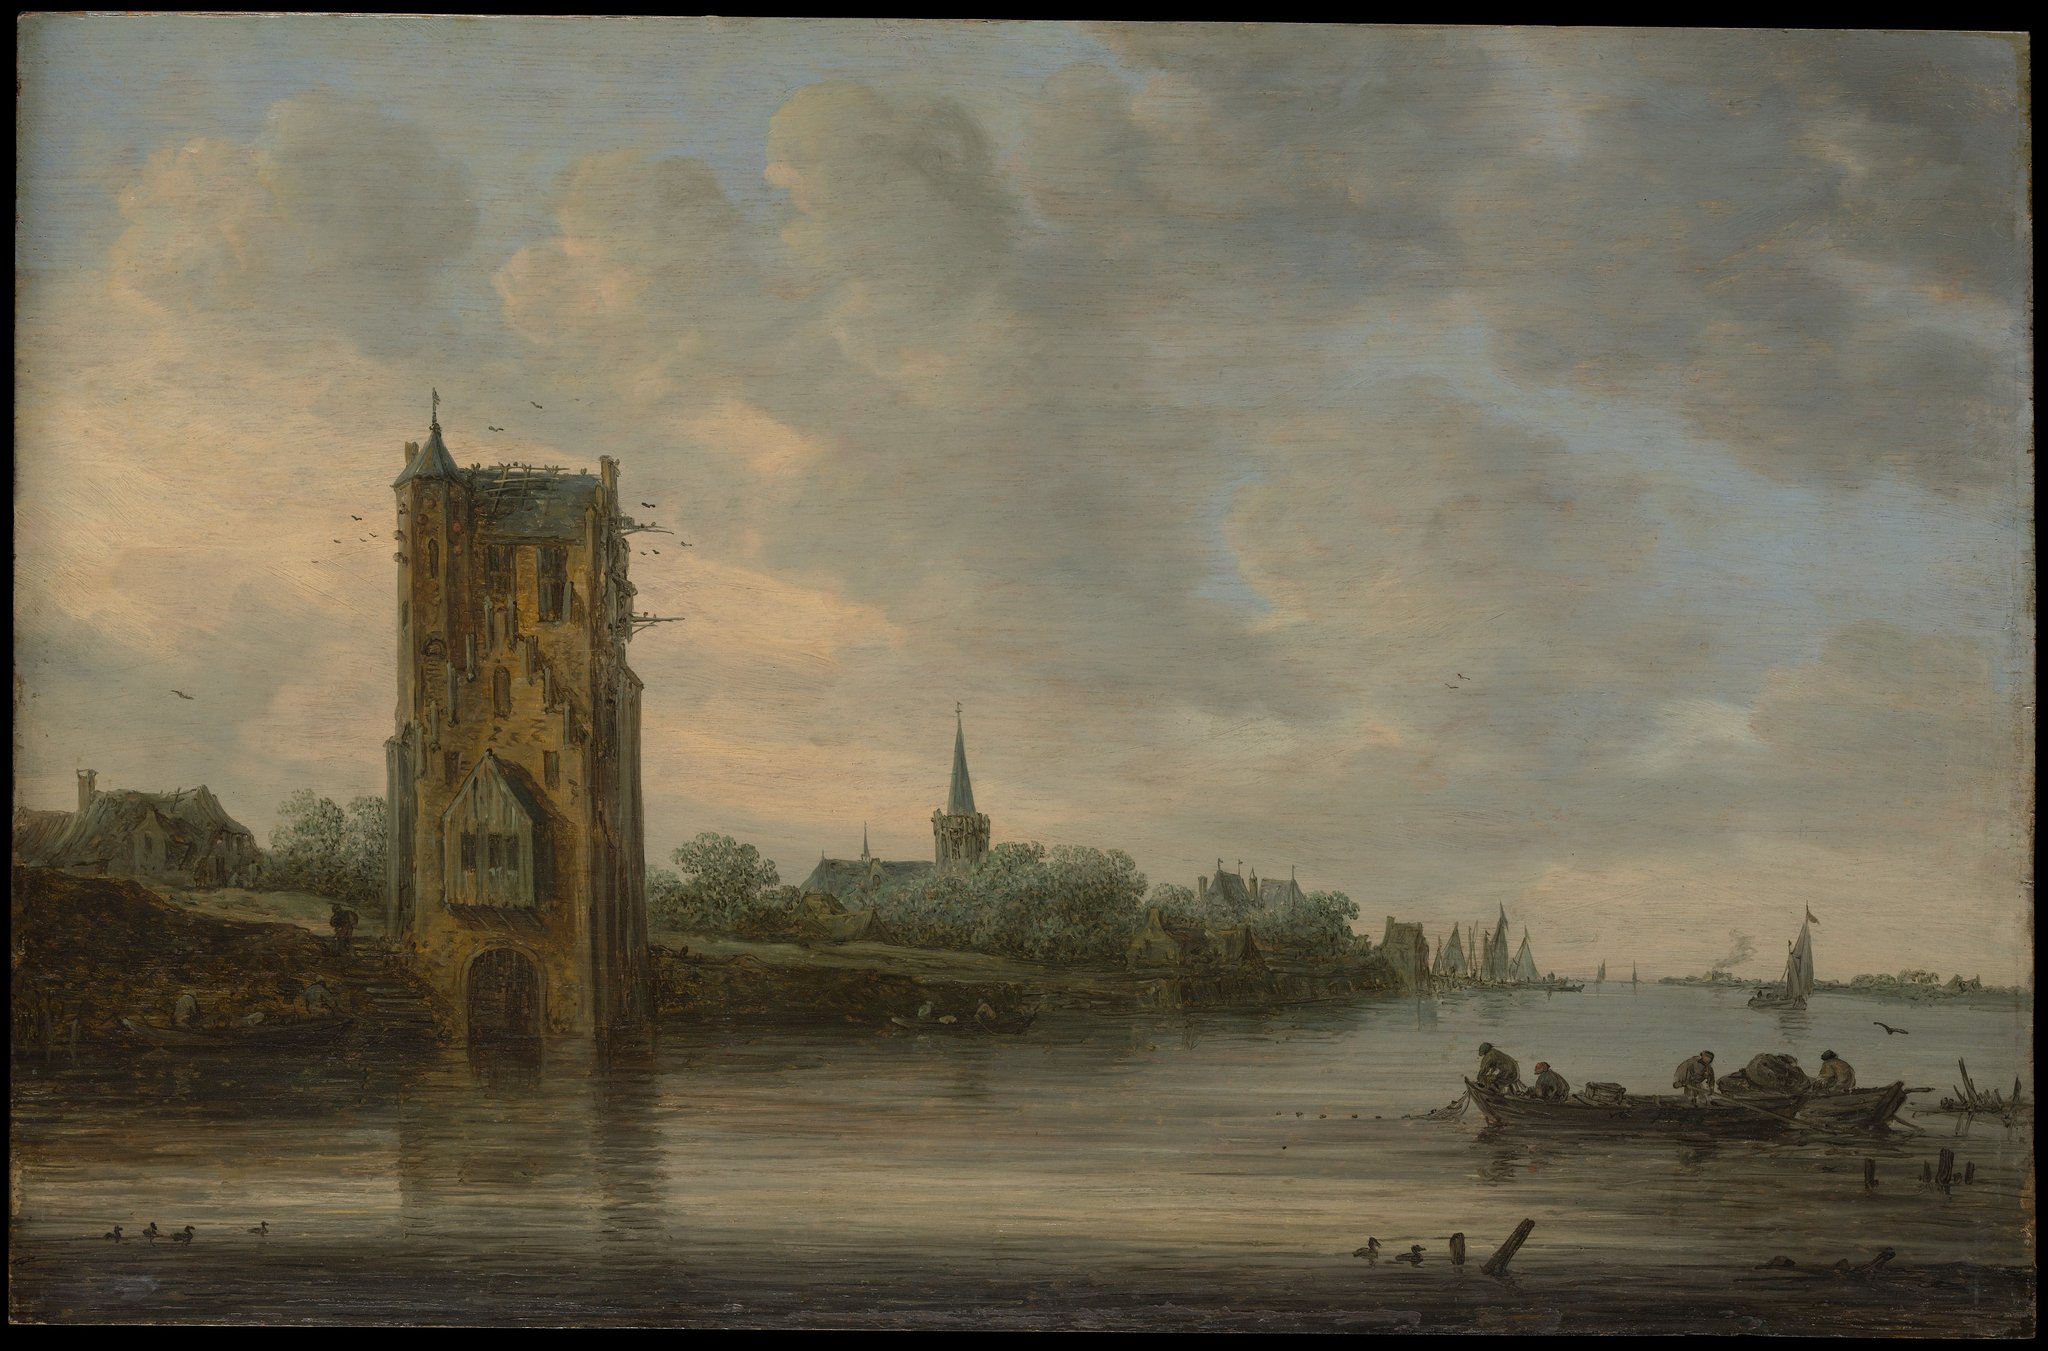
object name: painting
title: The Pelkus Gate near Utrecht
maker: jan van goyen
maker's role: artist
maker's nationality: dutch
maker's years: 1596-1656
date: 1646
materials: oil, wood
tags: human figures,gates,towers,rivers,boats